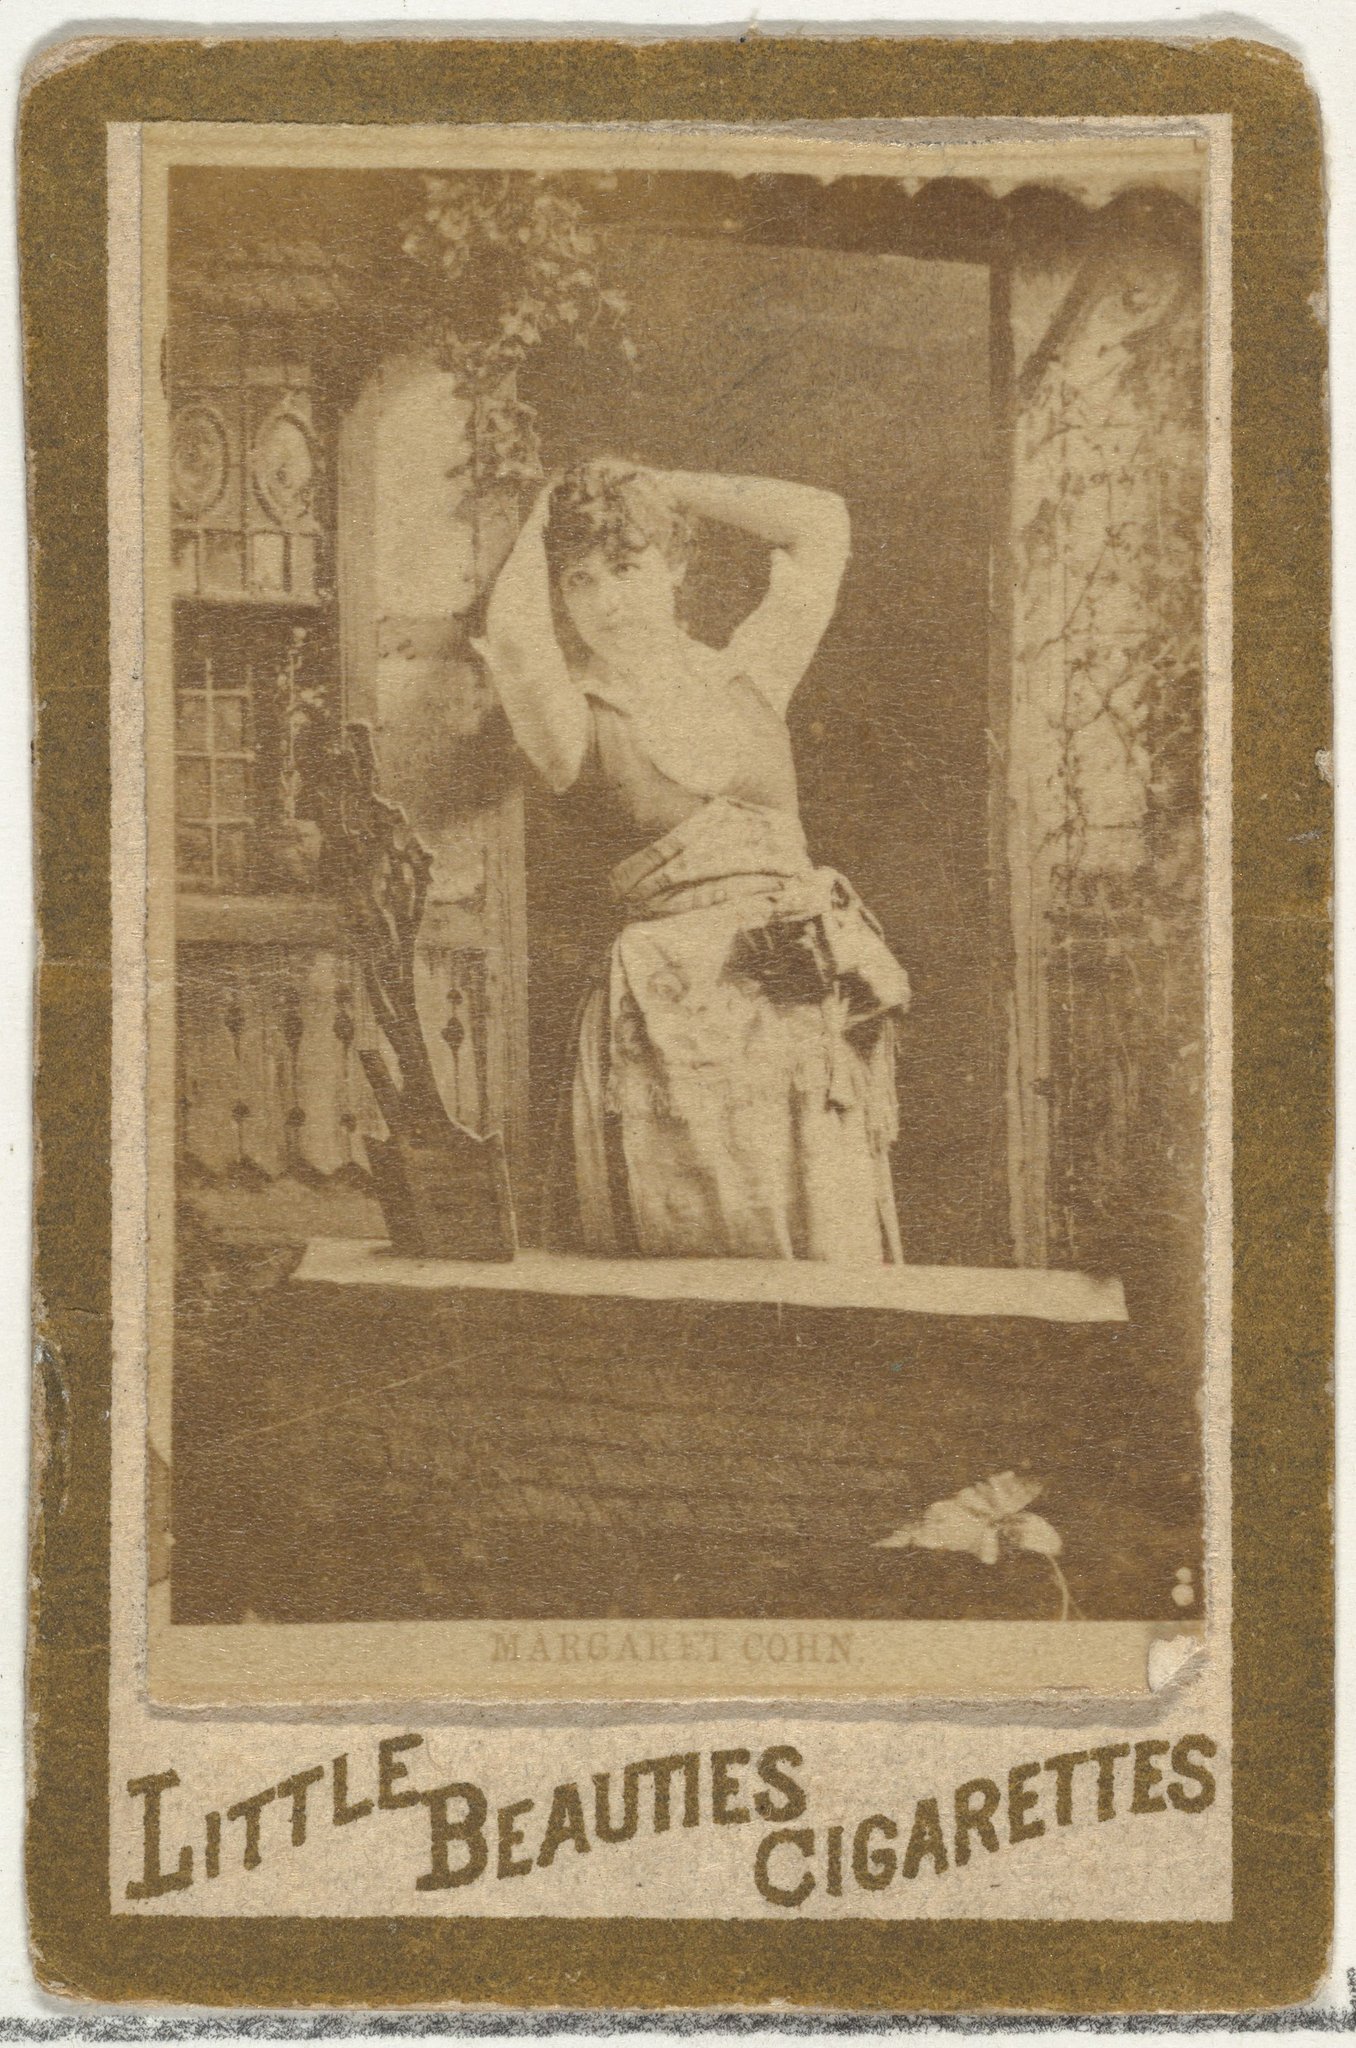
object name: photograph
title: Margaret Cohn, from the Actresses and Celebrities series (N60, Type 1) promoting Little Beauties Cigarettes for Allen & Ginter brand tobacco products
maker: allen & ginter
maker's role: publisher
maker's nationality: american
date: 1887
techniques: albumen silver print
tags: portraits,women,actresses